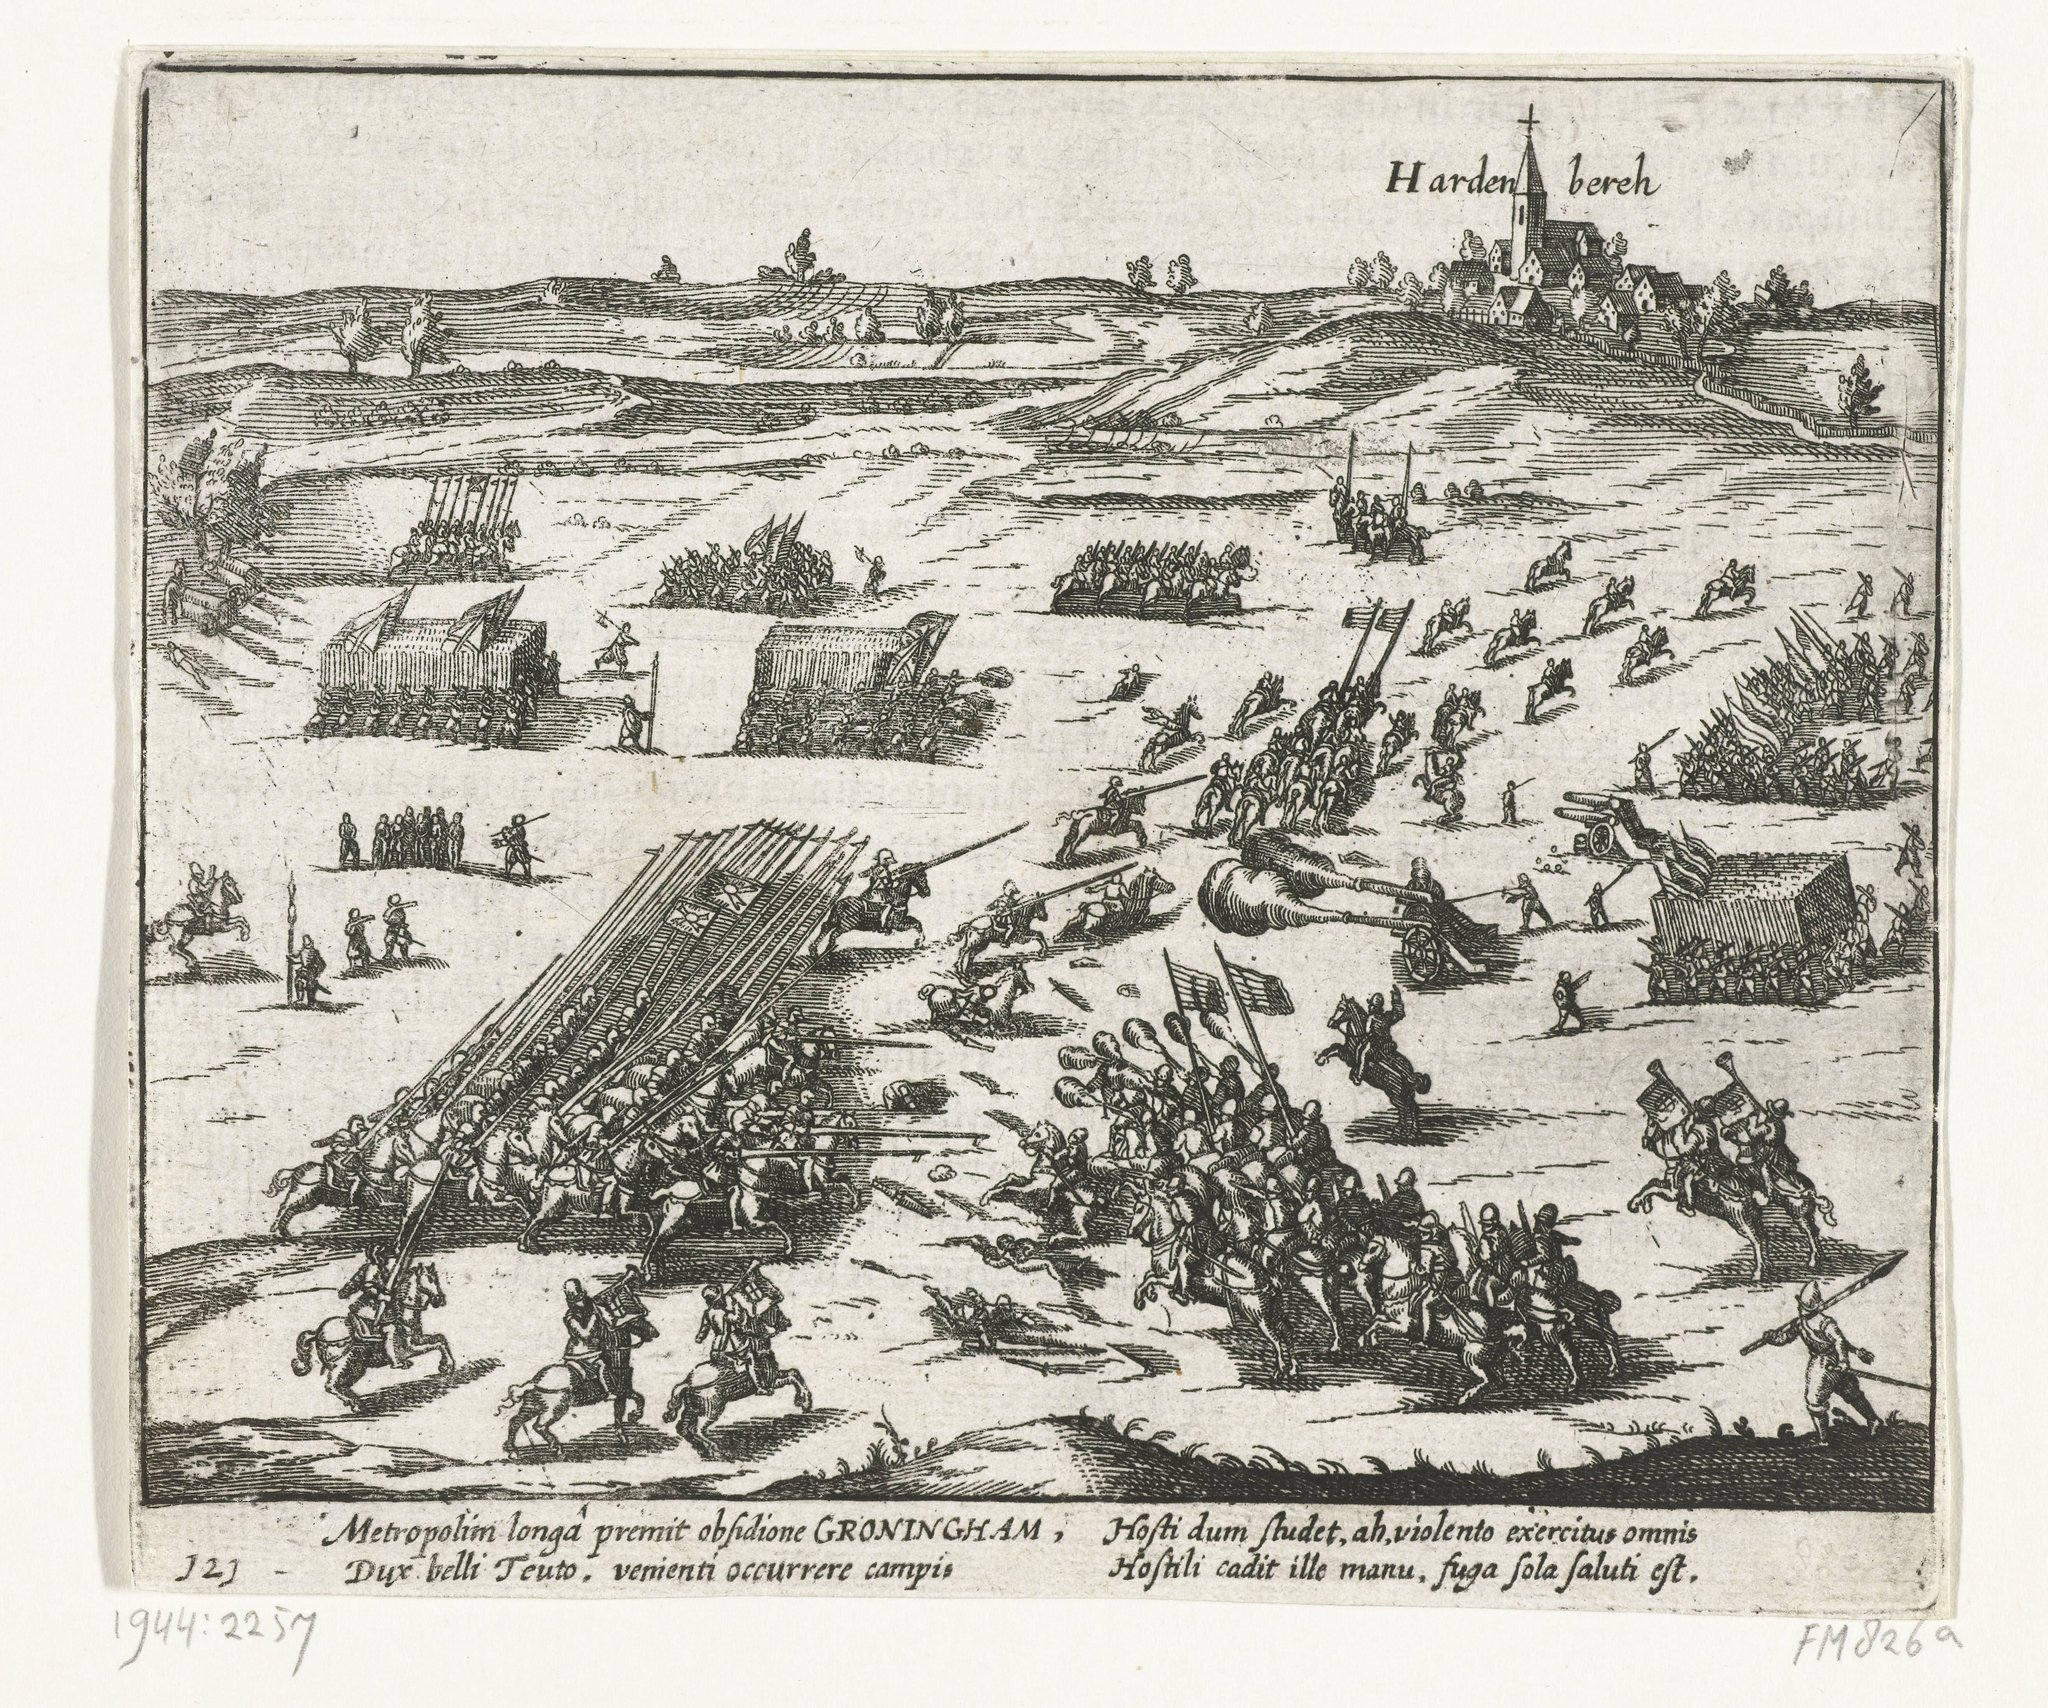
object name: history print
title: Slag bij Hardenberg, 1580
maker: Anonymous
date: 1613-1615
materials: paper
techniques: etching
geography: northern netherlands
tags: battle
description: Slag bij Hardenberg waarbij het Spaanse leger het Staatse leger onder bevel van Filips van Hohenlohe verslaat, 17 juni 1580. Gezicht op het slagveld met in de verte Hardenberg. Met onderschrift van 4 regels in het Latijn. Genummerd 121. Bedrukt op achterzijde met tekst in het Latijn.